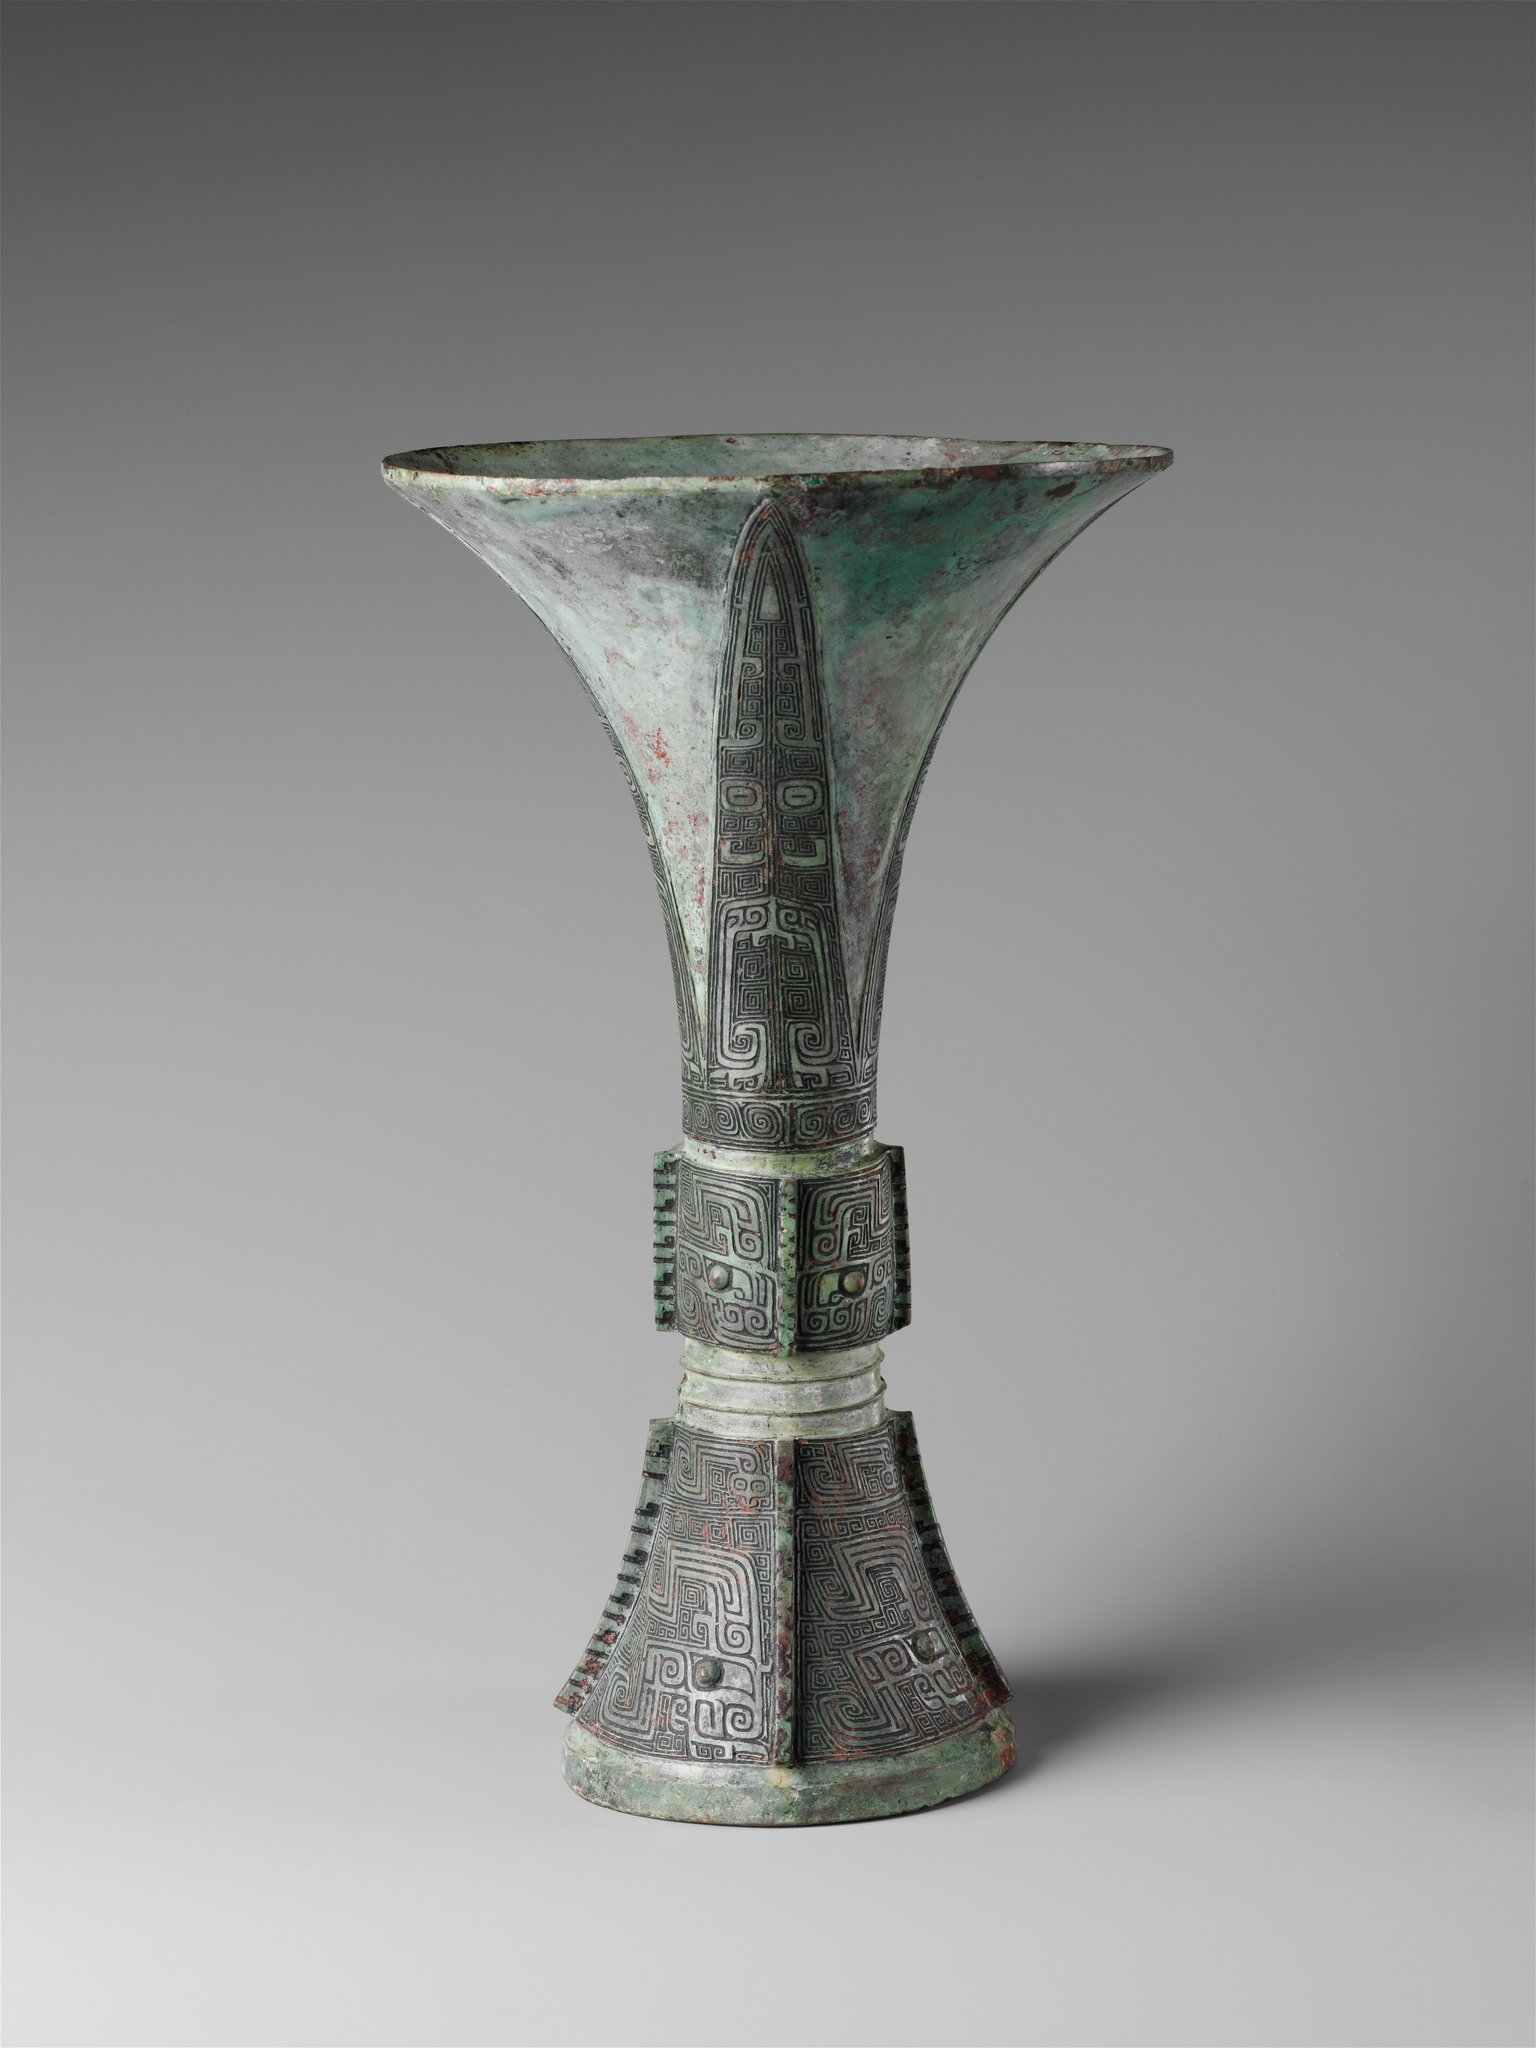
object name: wine beaker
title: Wine beaker (gu)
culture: chinese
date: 1300-1201 BCE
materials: bronze, pigment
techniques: inlay